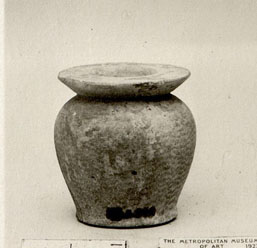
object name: kohl jar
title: Kohl pot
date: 1802-1640 BCE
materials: stone